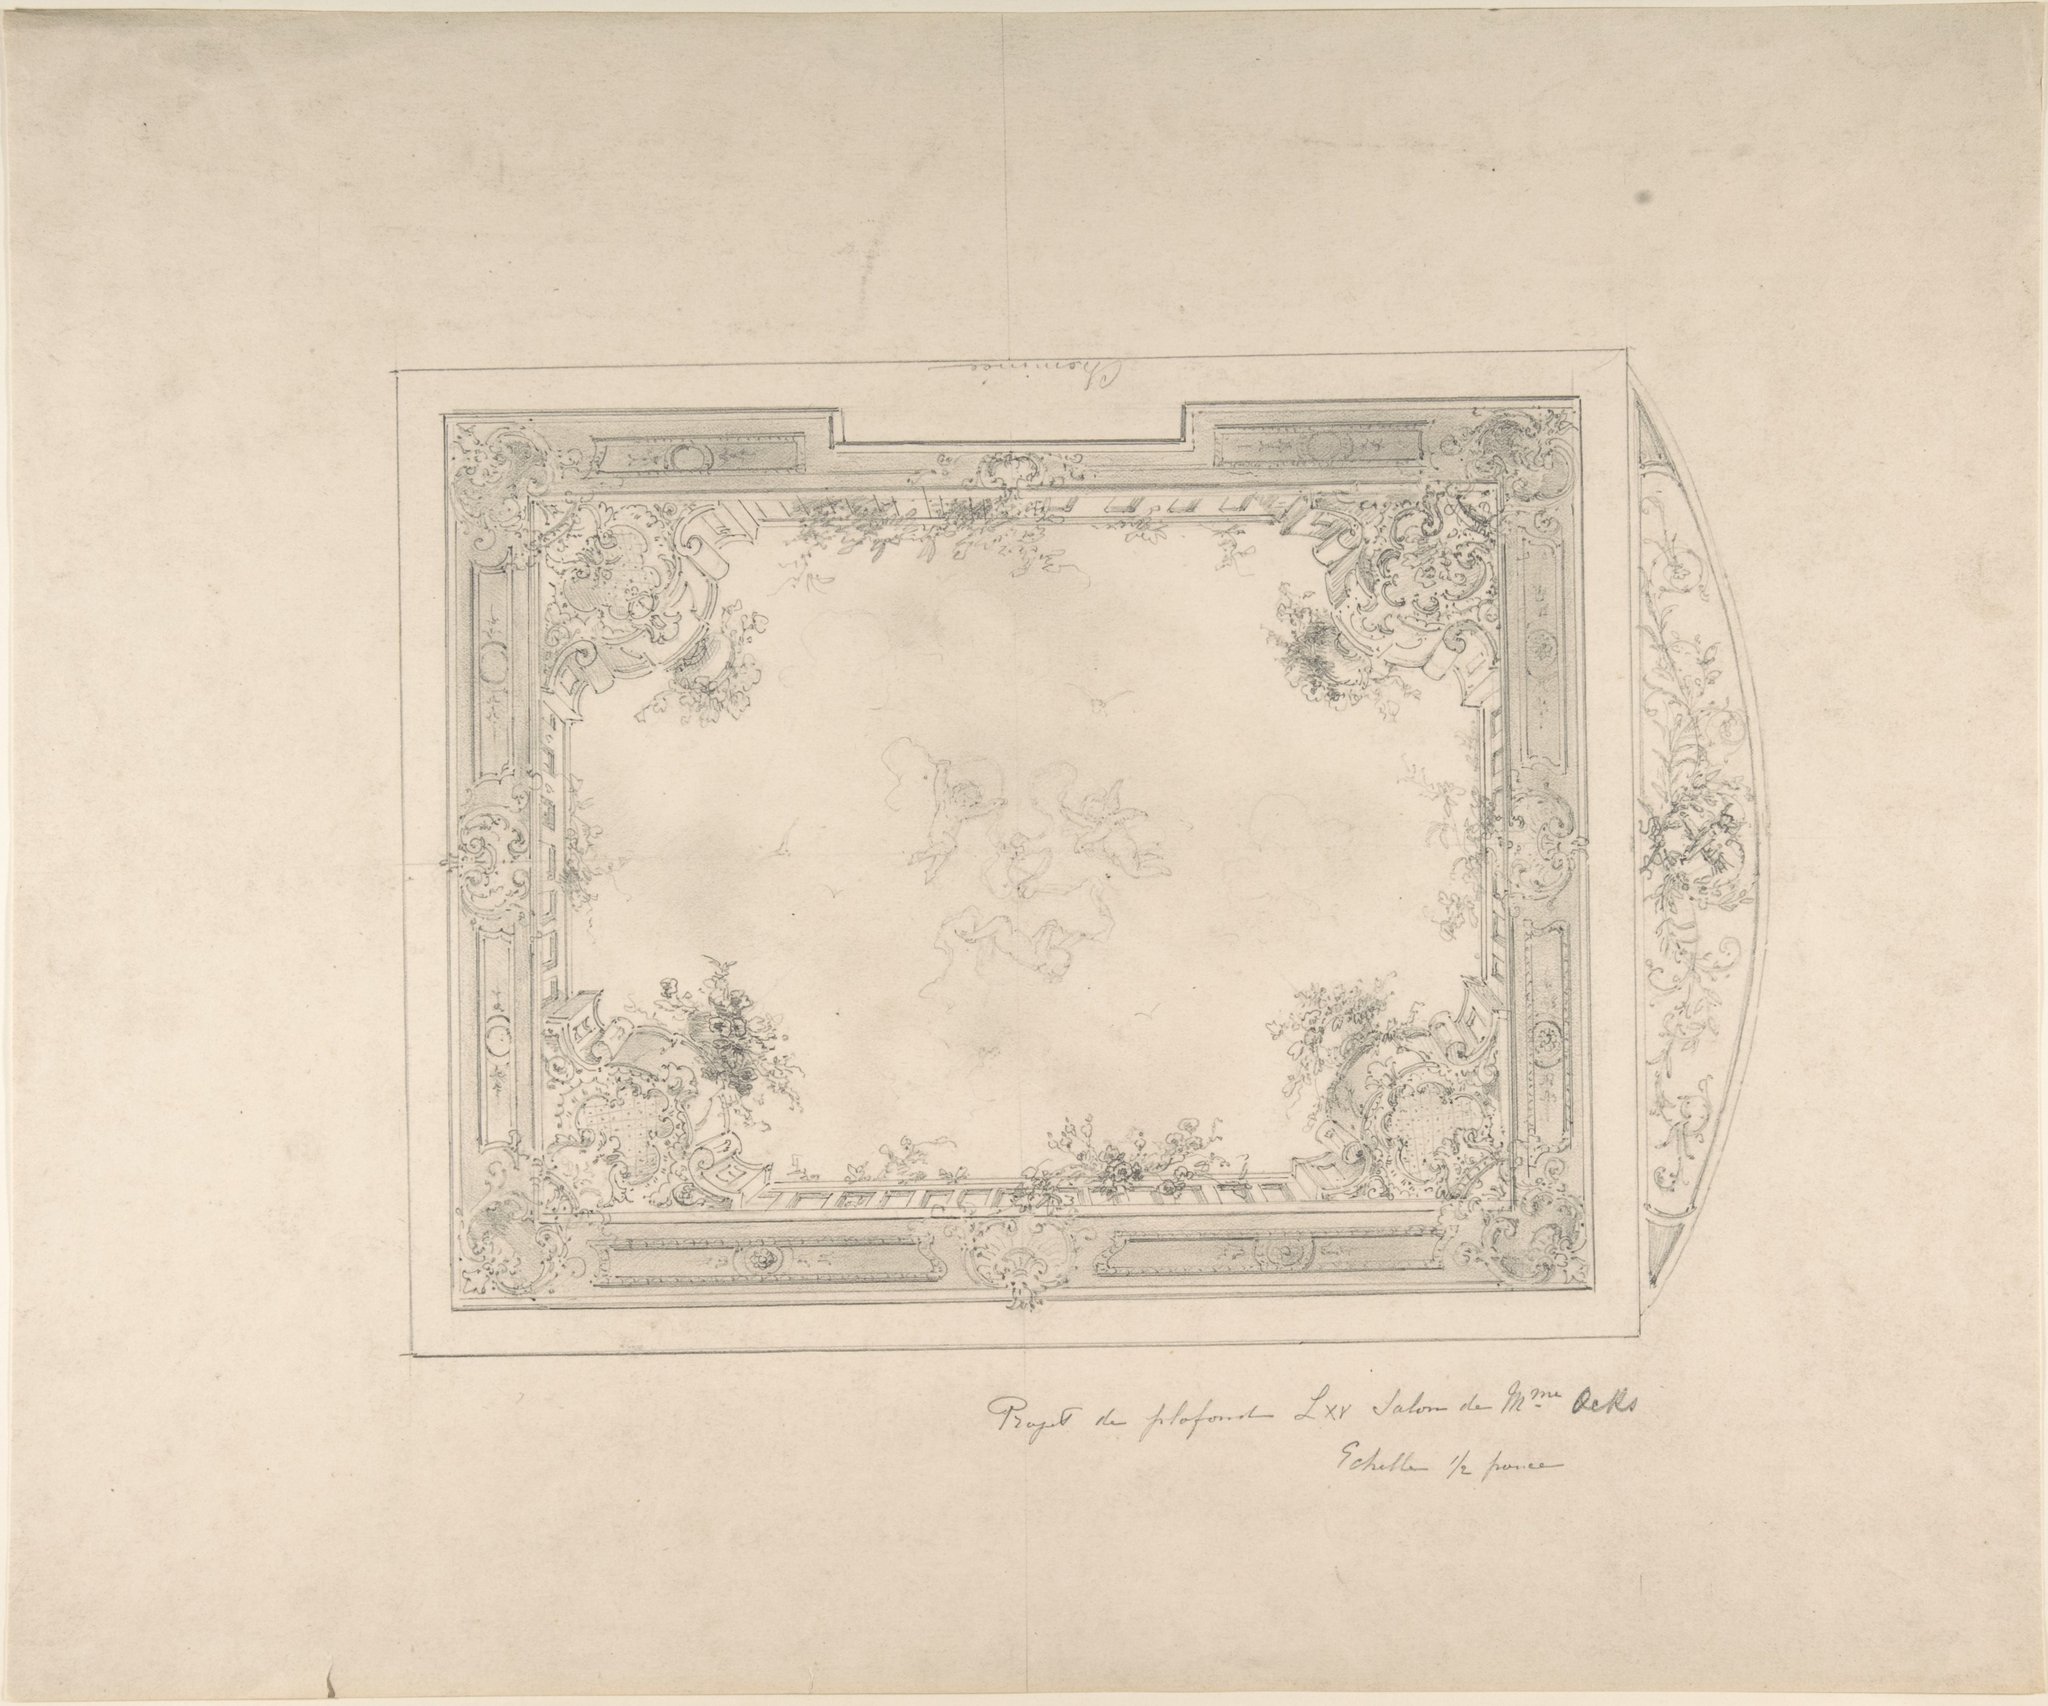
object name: drawing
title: Design for Ceiling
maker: charles monblond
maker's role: artist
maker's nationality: french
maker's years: 1800-1900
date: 1801-1900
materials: graphite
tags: cartouches